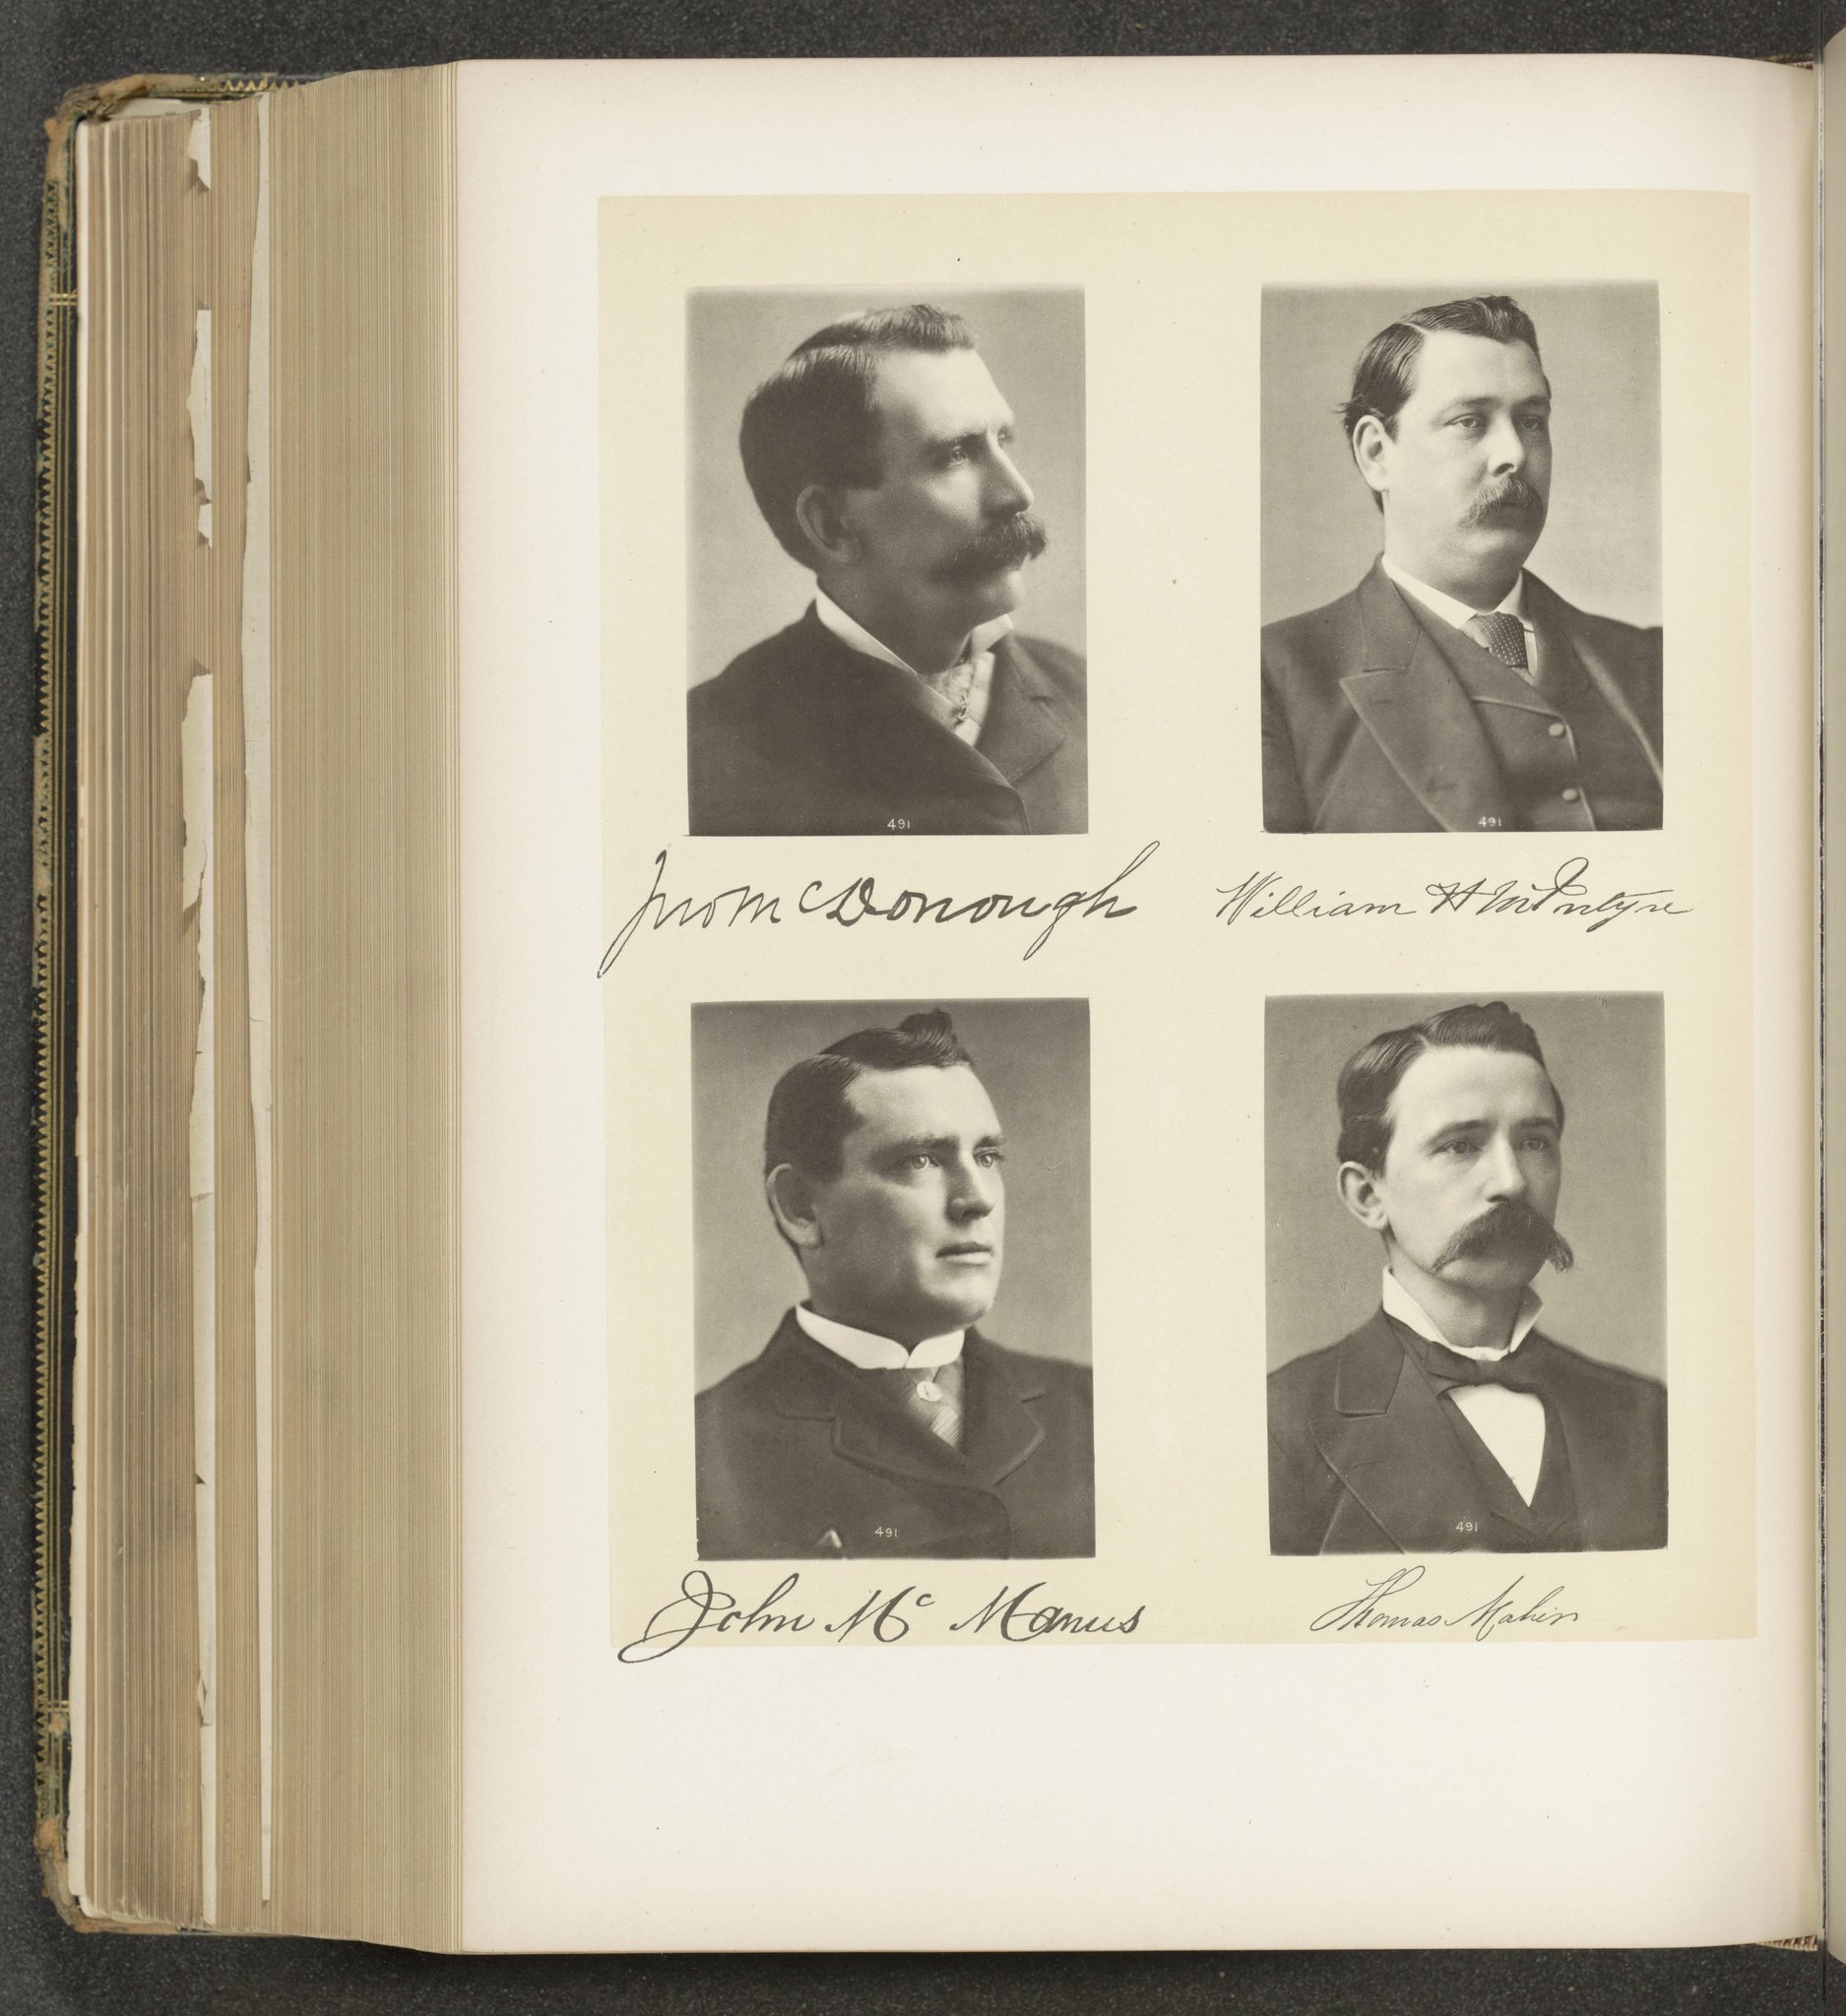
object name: photomechanical print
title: Portretten van vier leden van het Lagerhuis van de staat New York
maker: Anonymous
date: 1872-1882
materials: paper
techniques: photograph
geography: united states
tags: historical persons (portraits and scenes from the life) (+ head (and shoulders) (portrait))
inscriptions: annotation, number: ‘491’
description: Linksboven John McDonough, rechtsboven William H. McIntyre, linksonder John McManus, rechtsonder Thomas Maher.